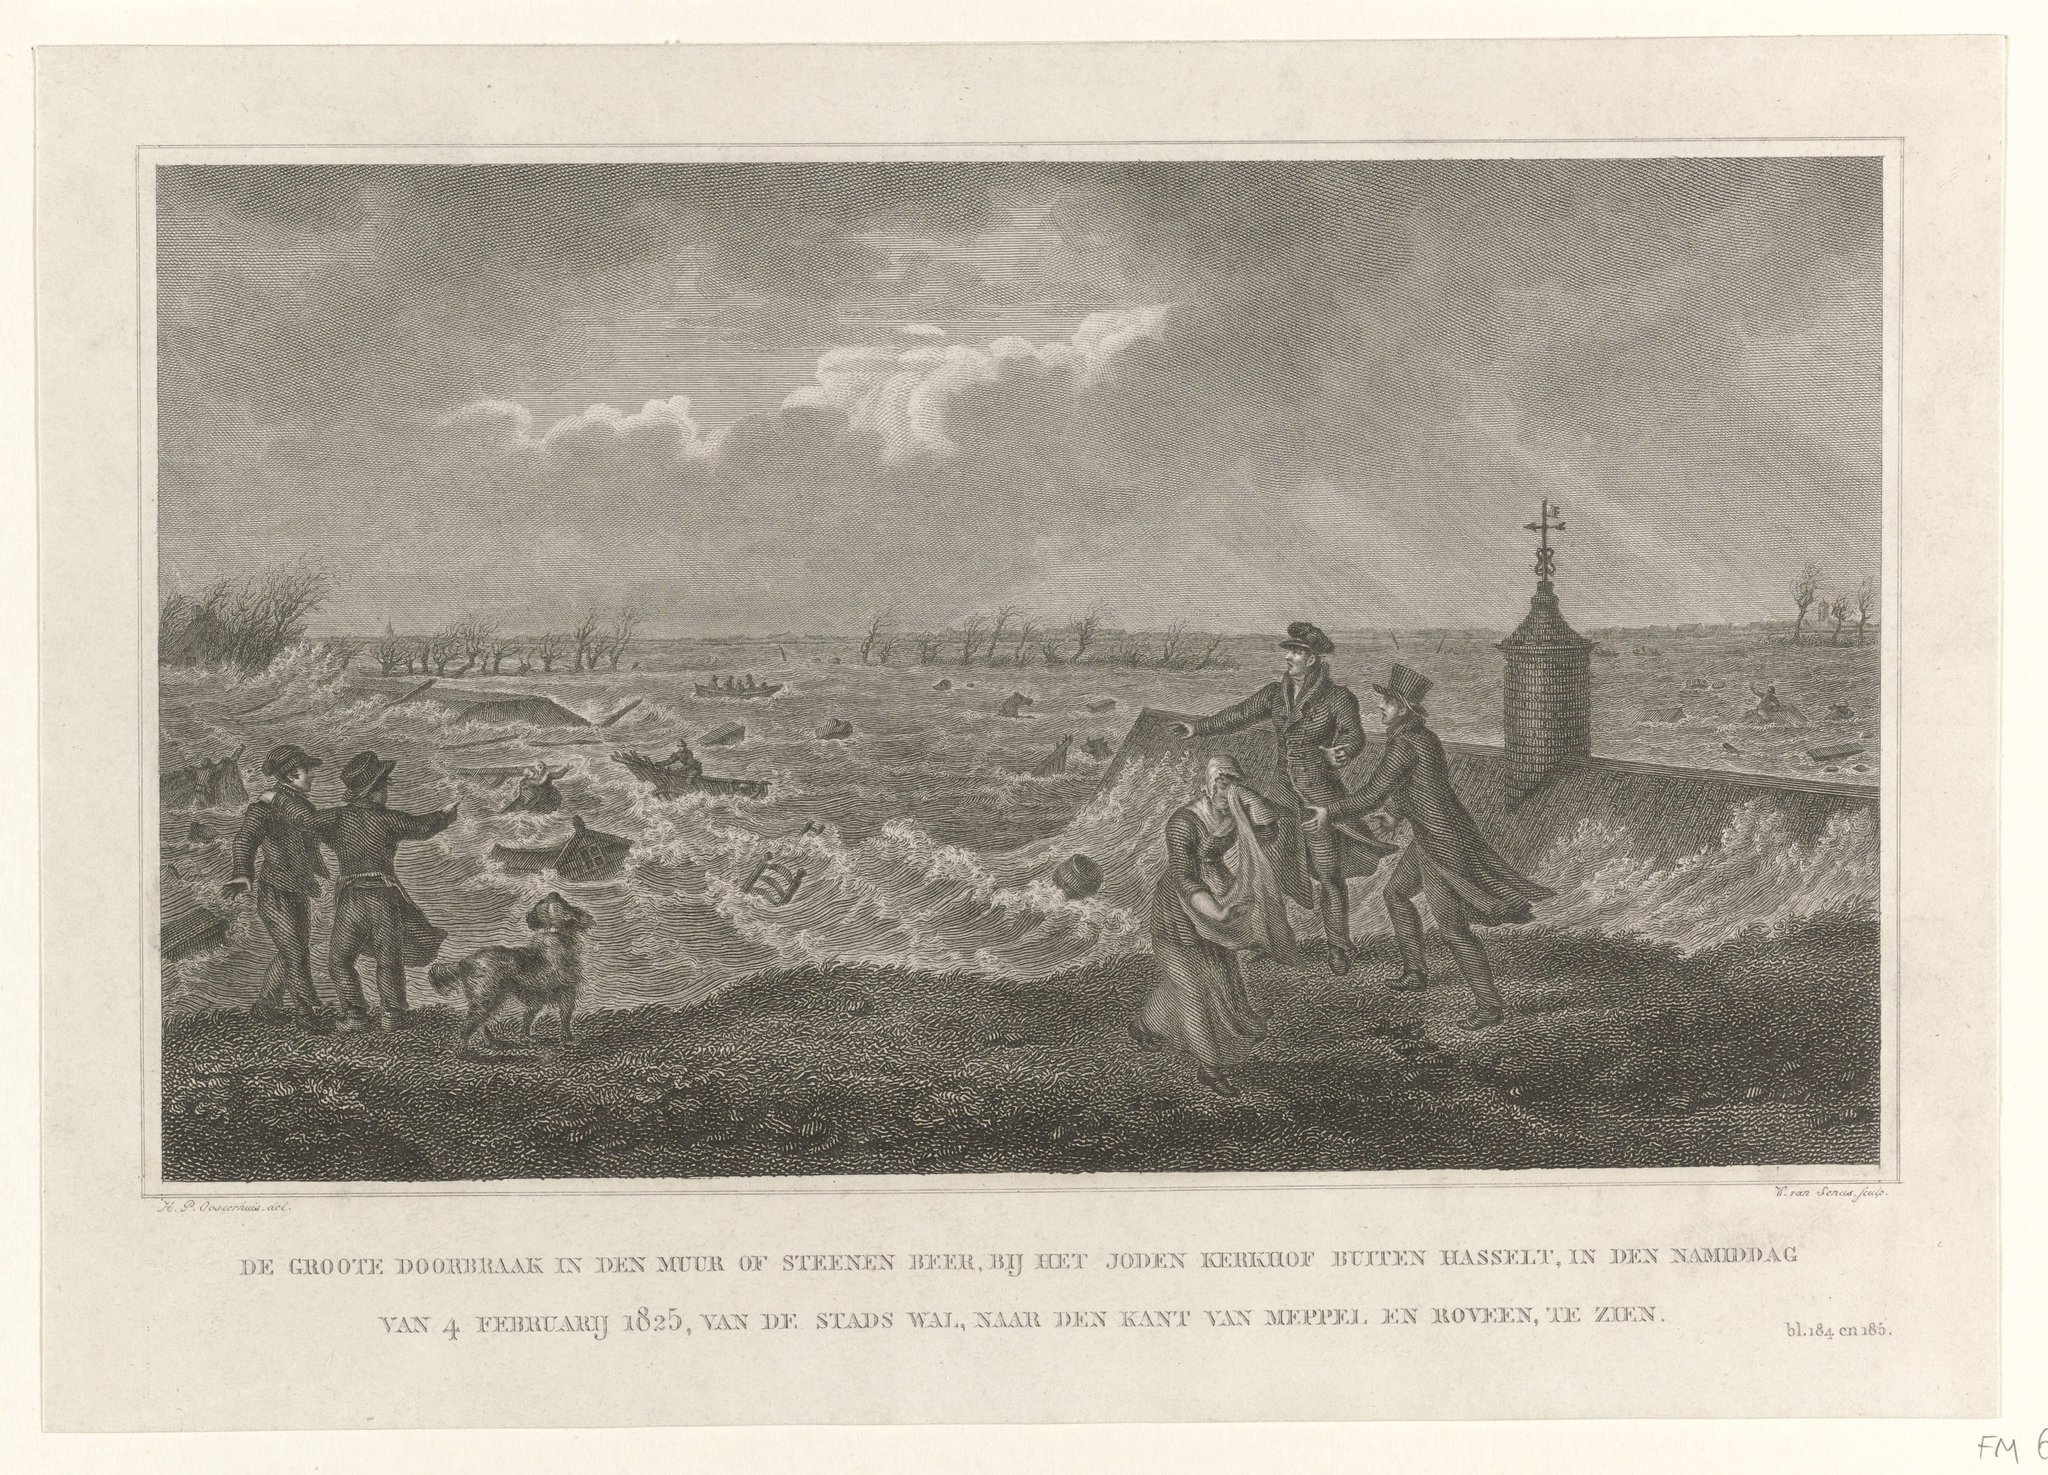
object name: print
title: De groote doorbraak in den muur of steenen beer, bij het joden kerkhof buiten Hasselt, in den namiddag van 4 februarij 1825, van de stads wal, naar den kant van Meppel en Roveen, te zien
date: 1825-1826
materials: paper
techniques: engraving, etching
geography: netherlands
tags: flood, churchyard, cemetery, death and burial ~ jewish customs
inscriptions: collector's mark: Lugt 2228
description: Gebruikt als illustratie in: Nicolaas Swart, Historisch tafereel van den zwaren watersnood, op den 3den, 4den en 5den Februarij 1825, een groot deel van ons vaderland hebbende getroffen. Amsterdam : bij Schalekamp en Van de Grampel, 1826, p. 184.